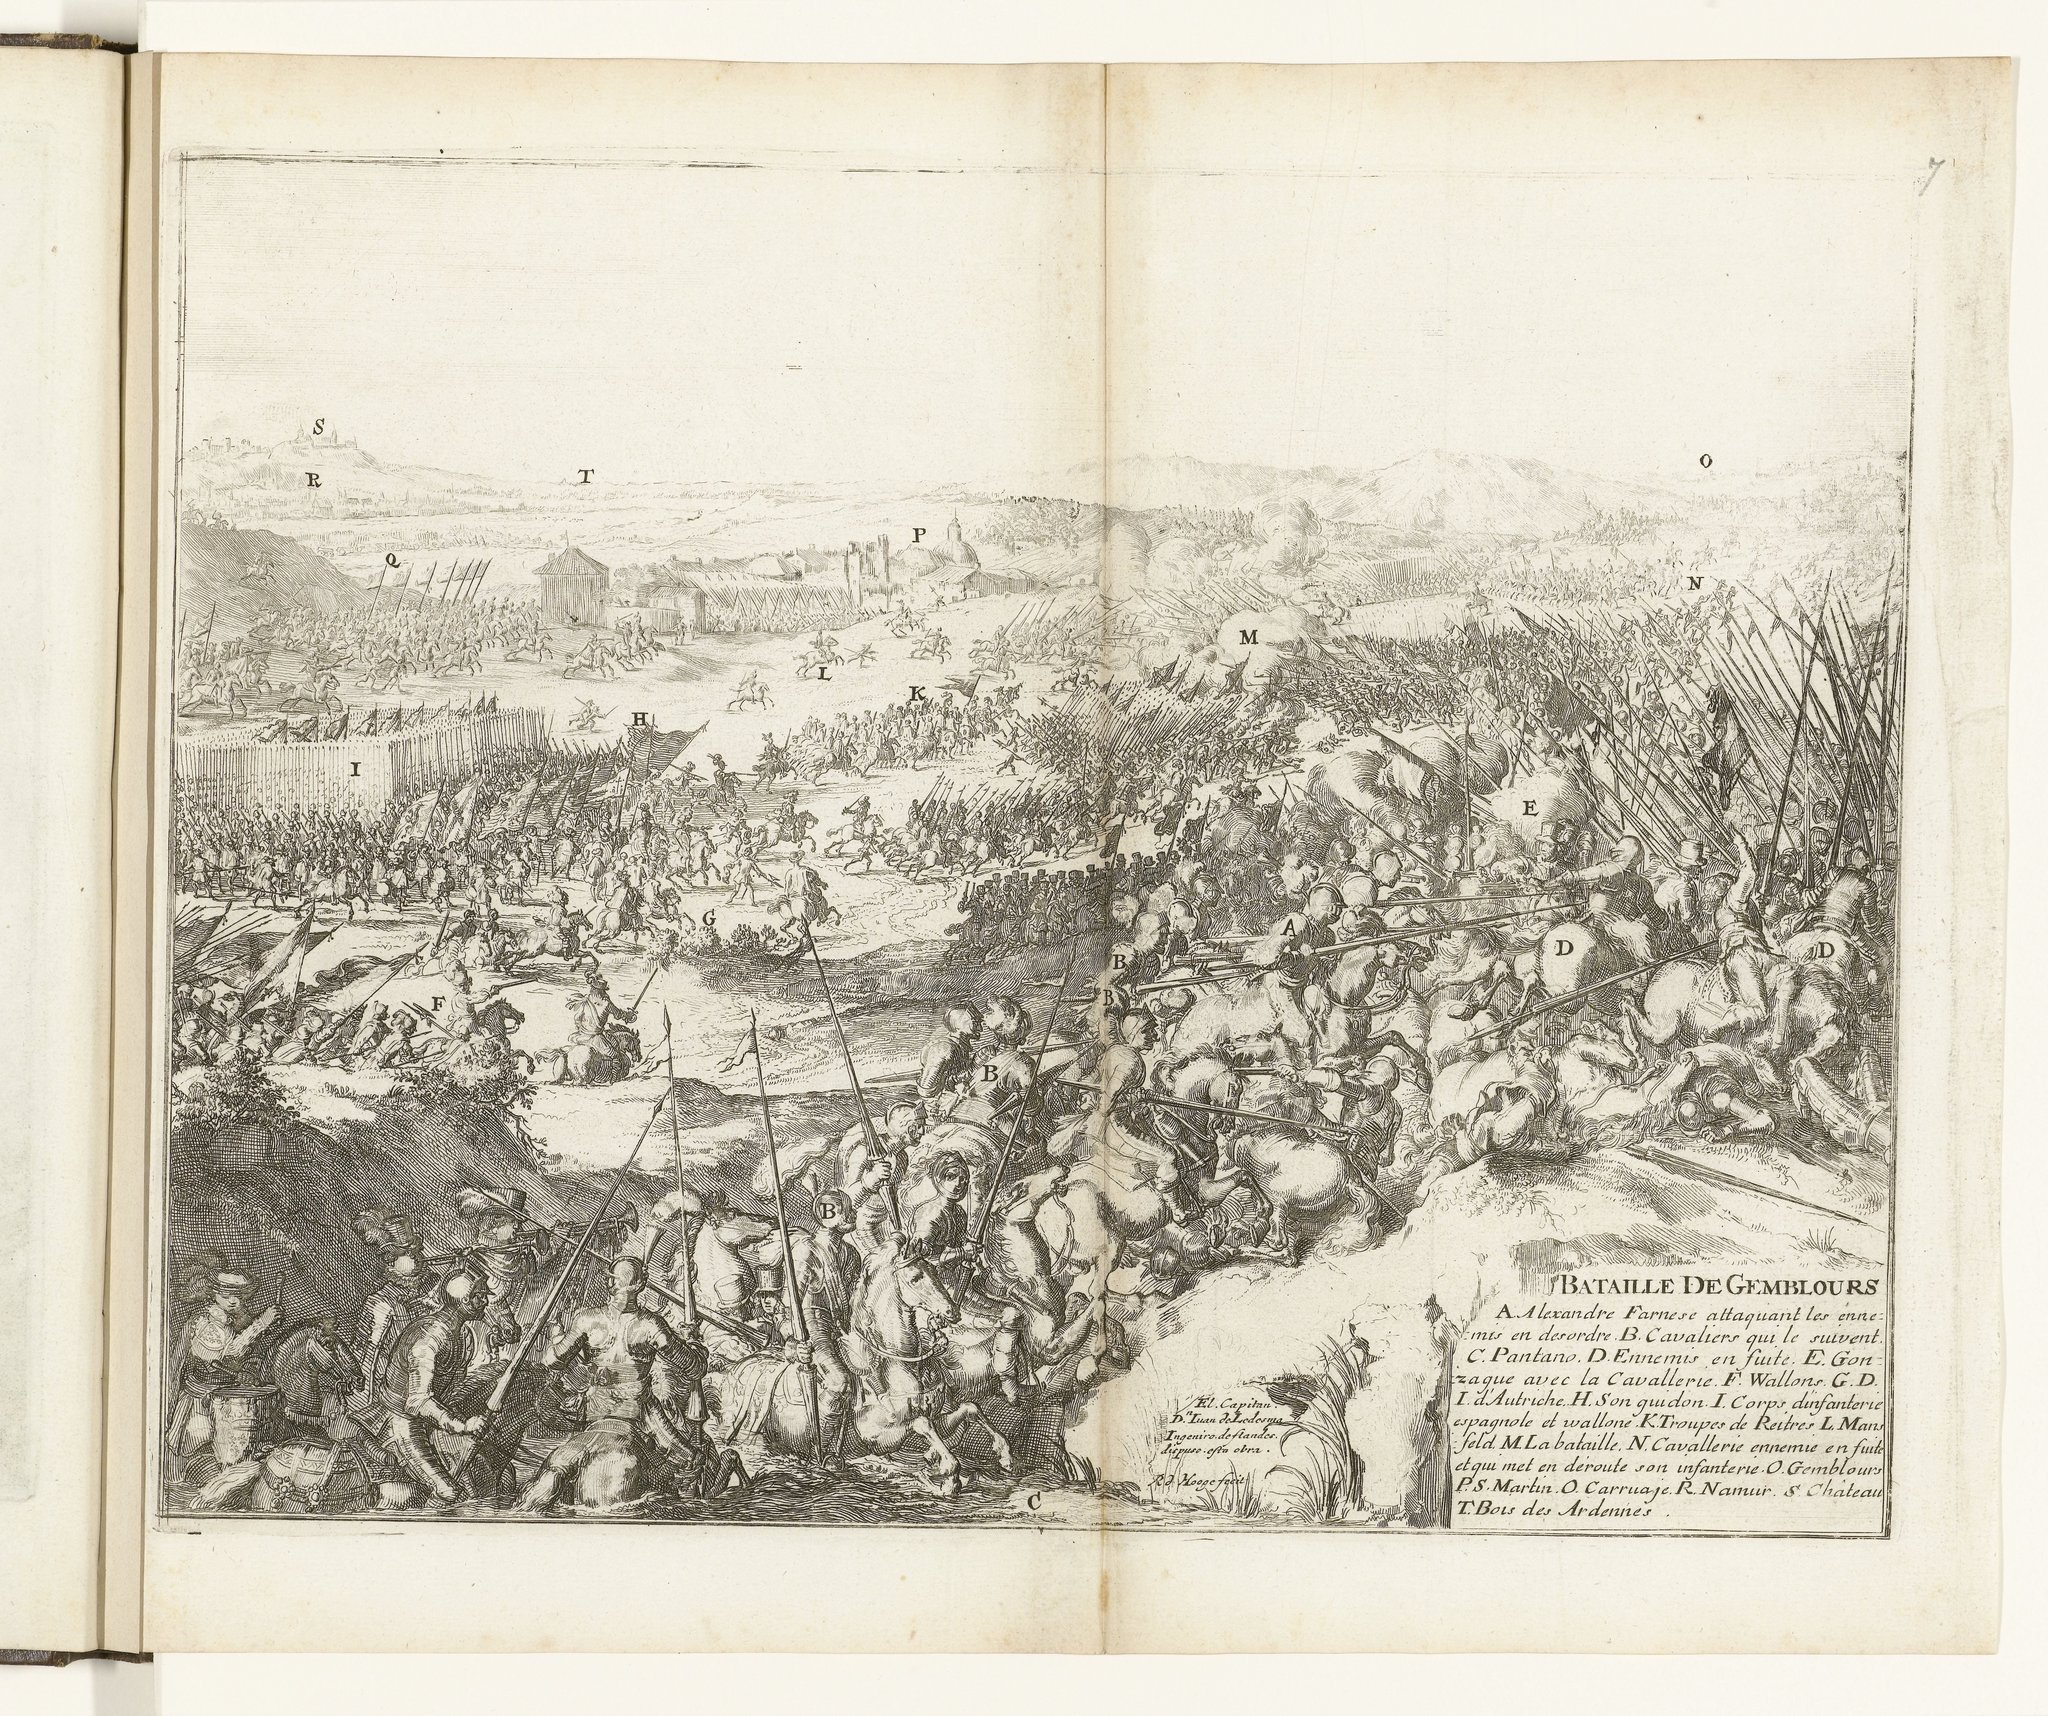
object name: history print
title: Slag bij Gemblours, 1578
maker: romeyn de hooghe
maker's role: draughtsman, goldsmith, painter, print maker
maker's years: 1645-1708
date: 1670-1699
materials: paper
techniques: etching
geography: netherlands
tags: rome, alessandro farnese (landvoogd van de nederlanden en hertog van parma en piacenza), battle, fighting in general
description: Waarschijnlijk oorspronkelijk vervaardigd voor een uitgave van Histoire de la guerre de Flandre, van F. Strada, eind 17e eeuw. De prent is onderdeel van een bundel van prenten en portretten getiteld Des Guerres de Flandres, in drie delen, met in totaal 22 batailles, 6 portretten en 3 titelprenten voor de afzonderlijke delen, alles (behalve de portretten) door De Hooghe en Ledesma in één band, ongenummerd en zonder titelblad (zie Rijksmuseum Research Library, inv.nr. BI-1929-10, 329 C 20). De prenten hebben betrekking op de periode 1567-1592.